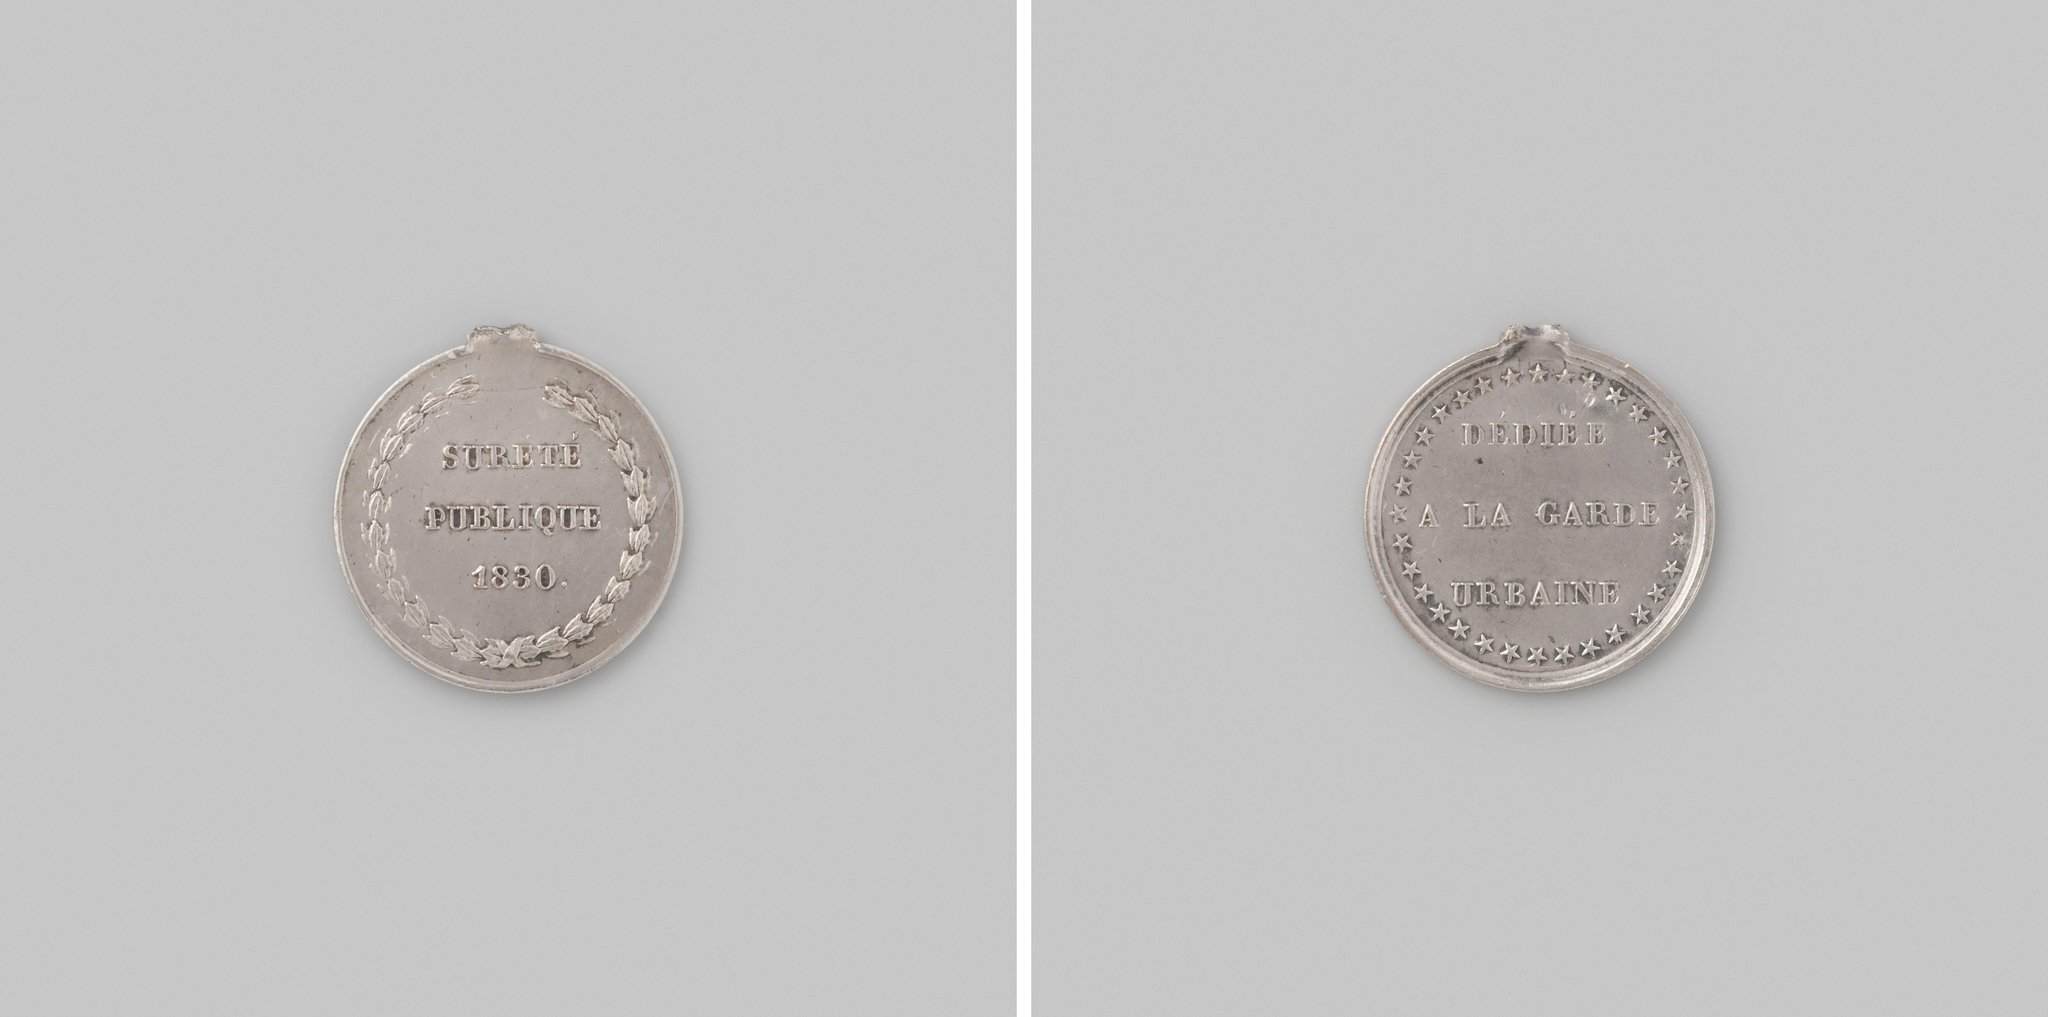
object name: insignia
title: Oprichting van burgerwachten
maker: Anonymous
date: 1830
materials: silver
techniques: striking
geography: belgium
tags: belgium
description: Zilveren penning aan afgebroken draagoog. Voorzijde: opschrift binnen lauwerkrans. Keerzijde: opschrift binnen sterrekrans.